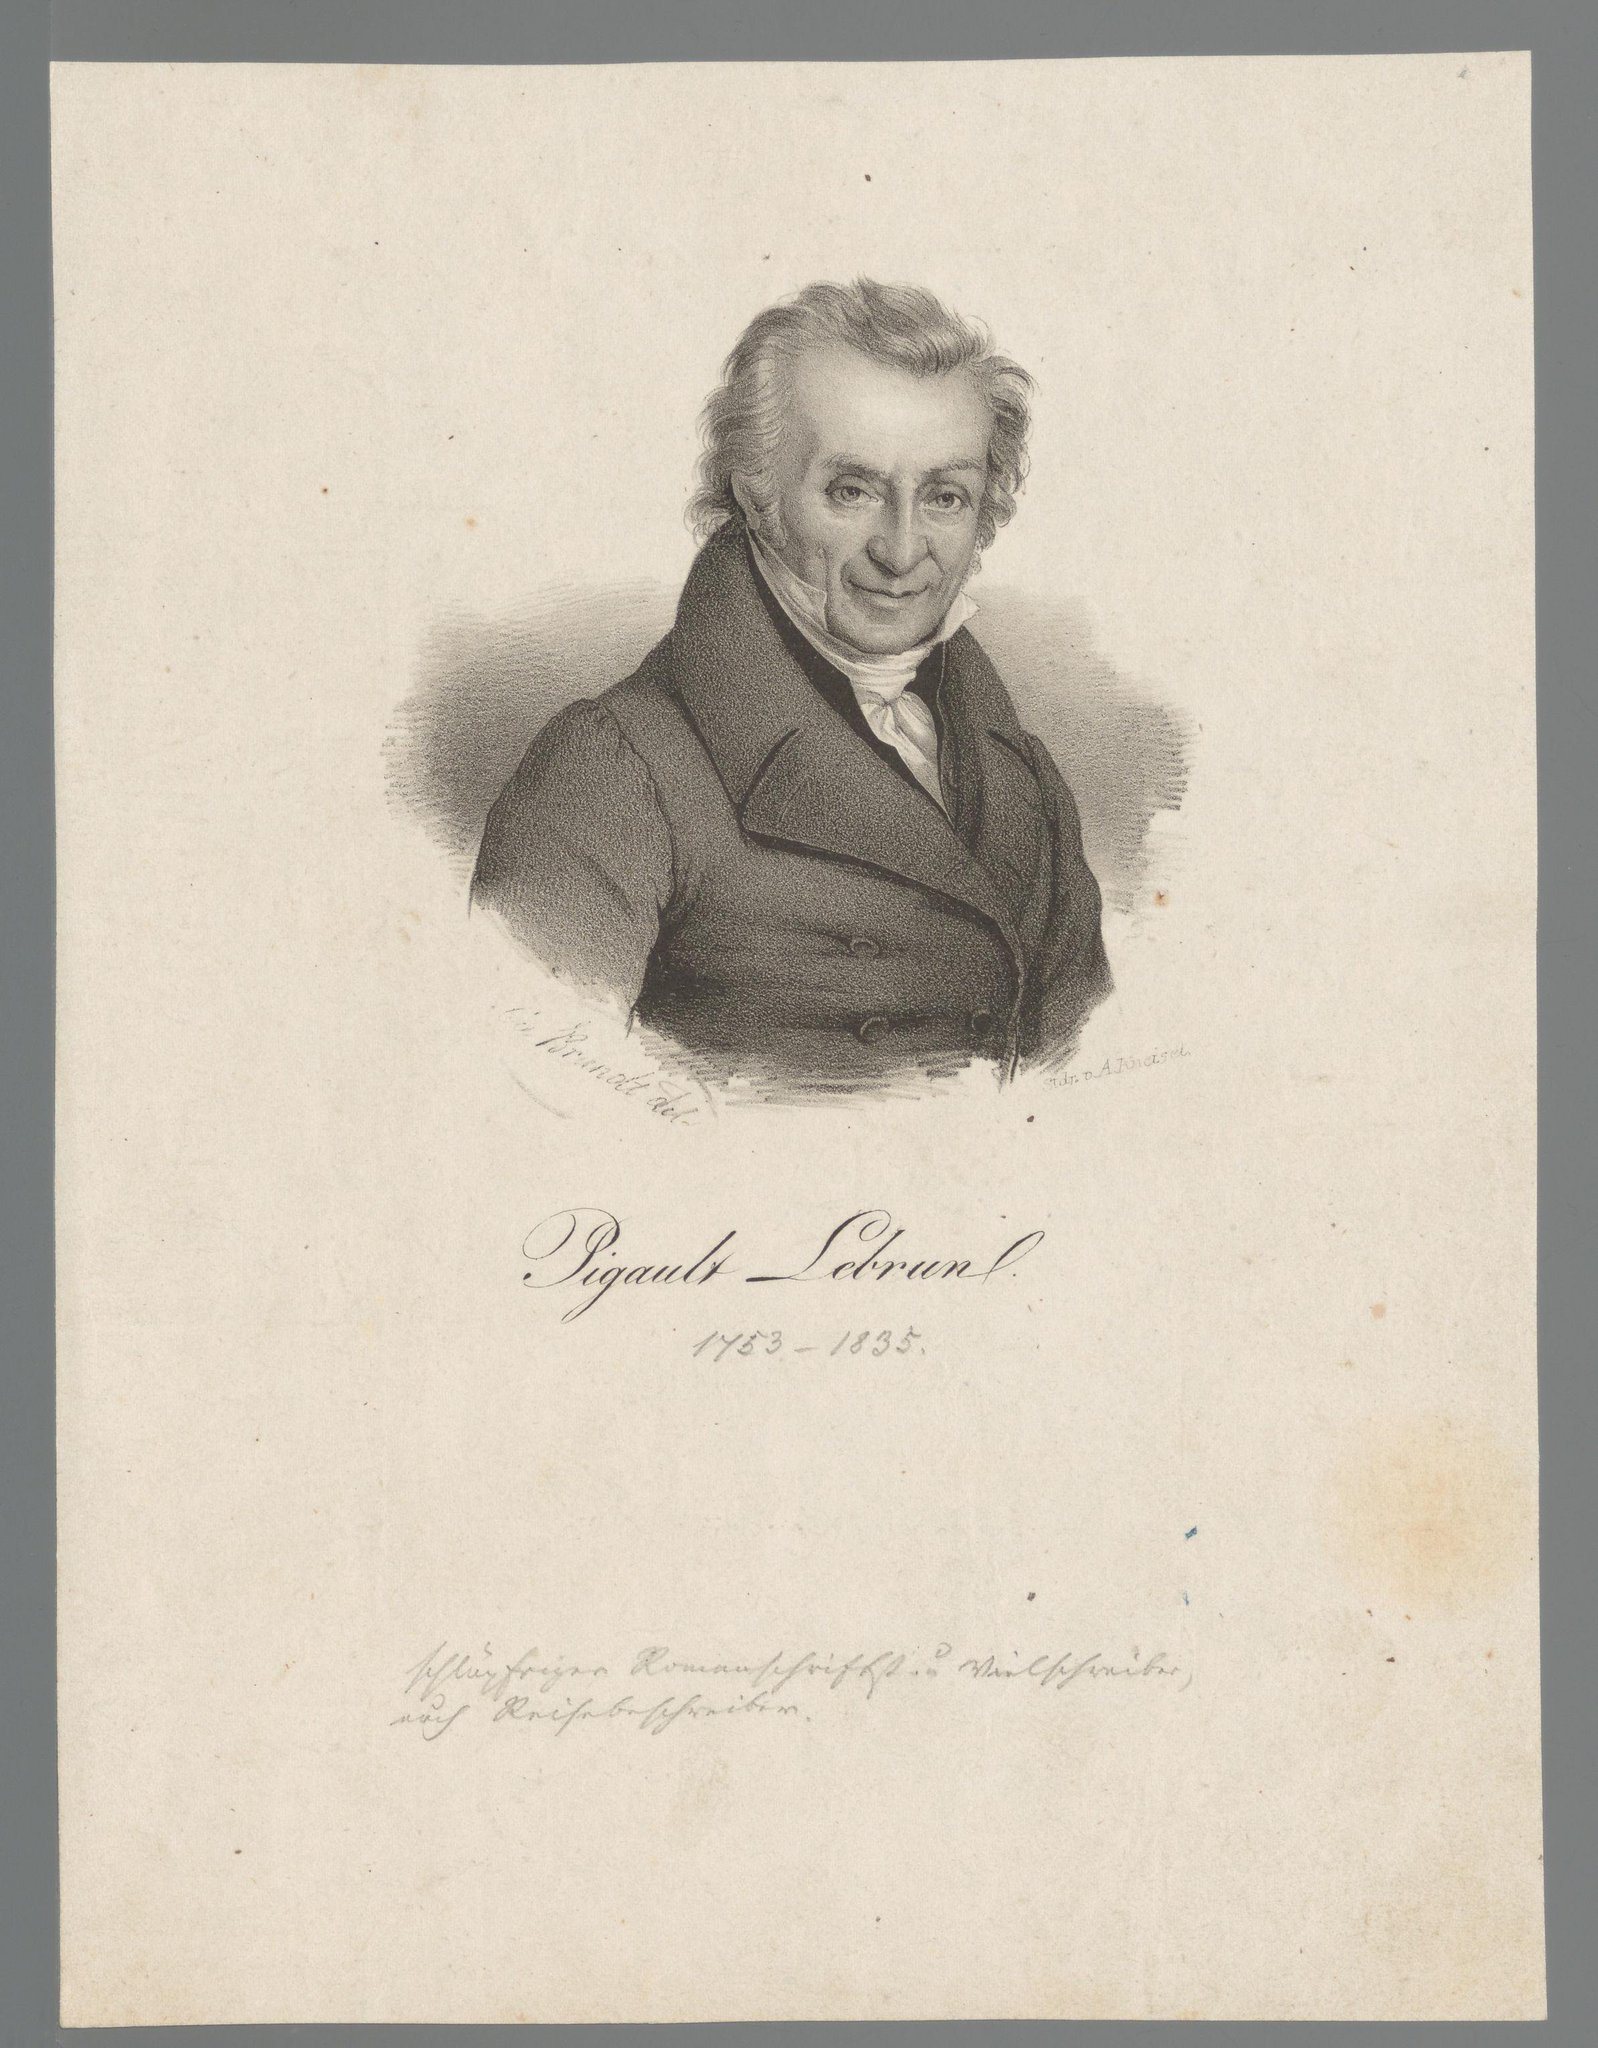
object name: print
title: Pigault Lebrun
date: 1825-1850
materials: paper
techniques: lithograph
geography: leipzig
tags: adult man, historical persons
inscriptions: collector's mark: Lugt 2228